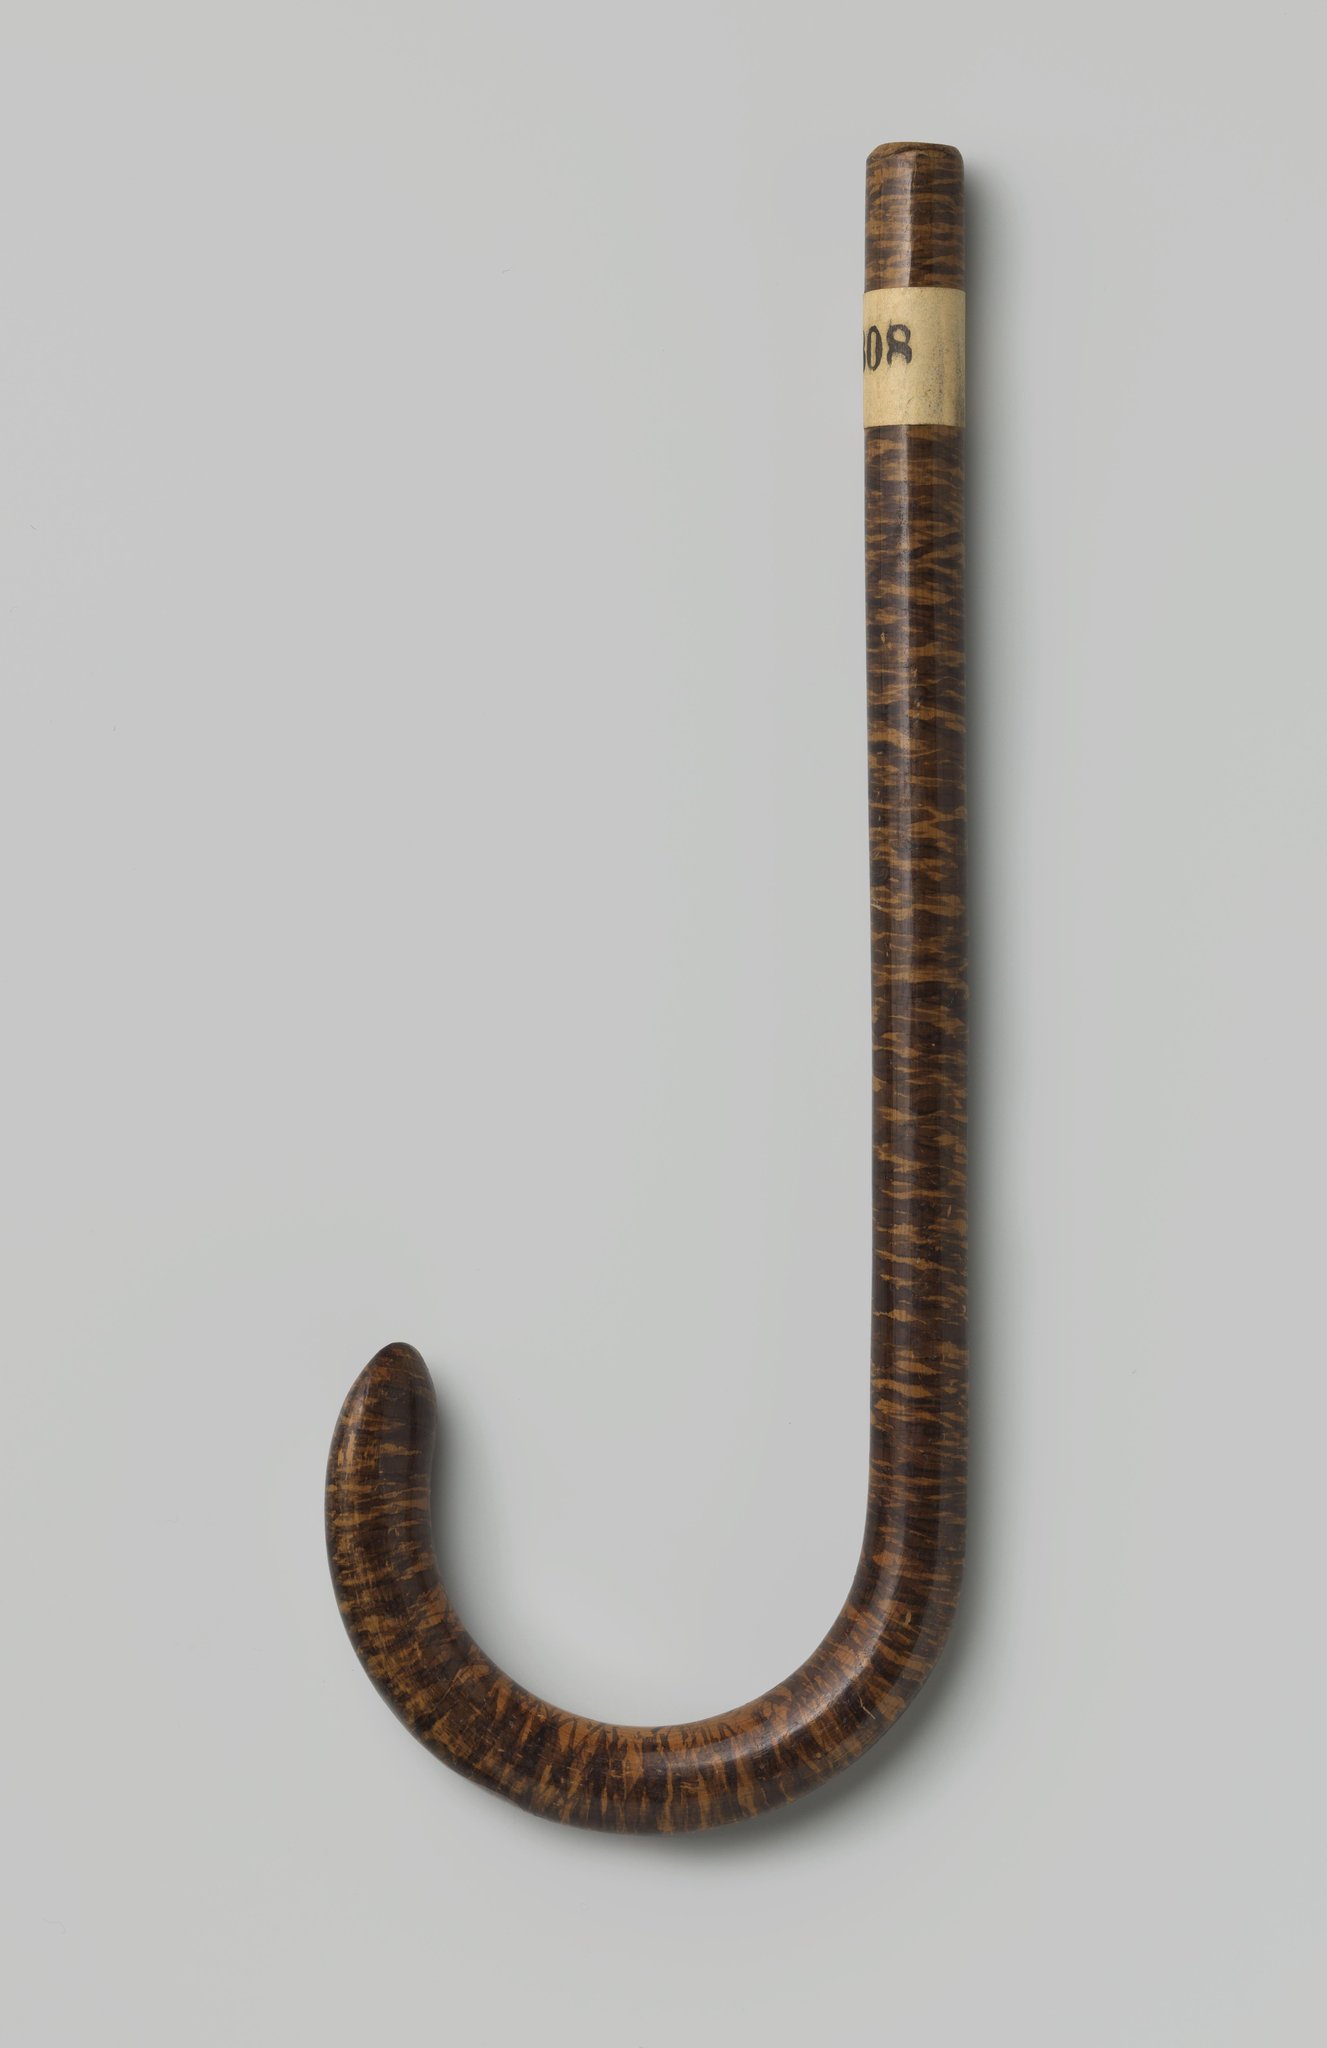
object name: parapluknop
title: Parasolknop van namaak schildpad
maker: Anonymous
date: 1910-1920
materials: tortoise shell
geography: netherlands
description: Grote ronde paraplu- of parasolknop van namaakschildpad.